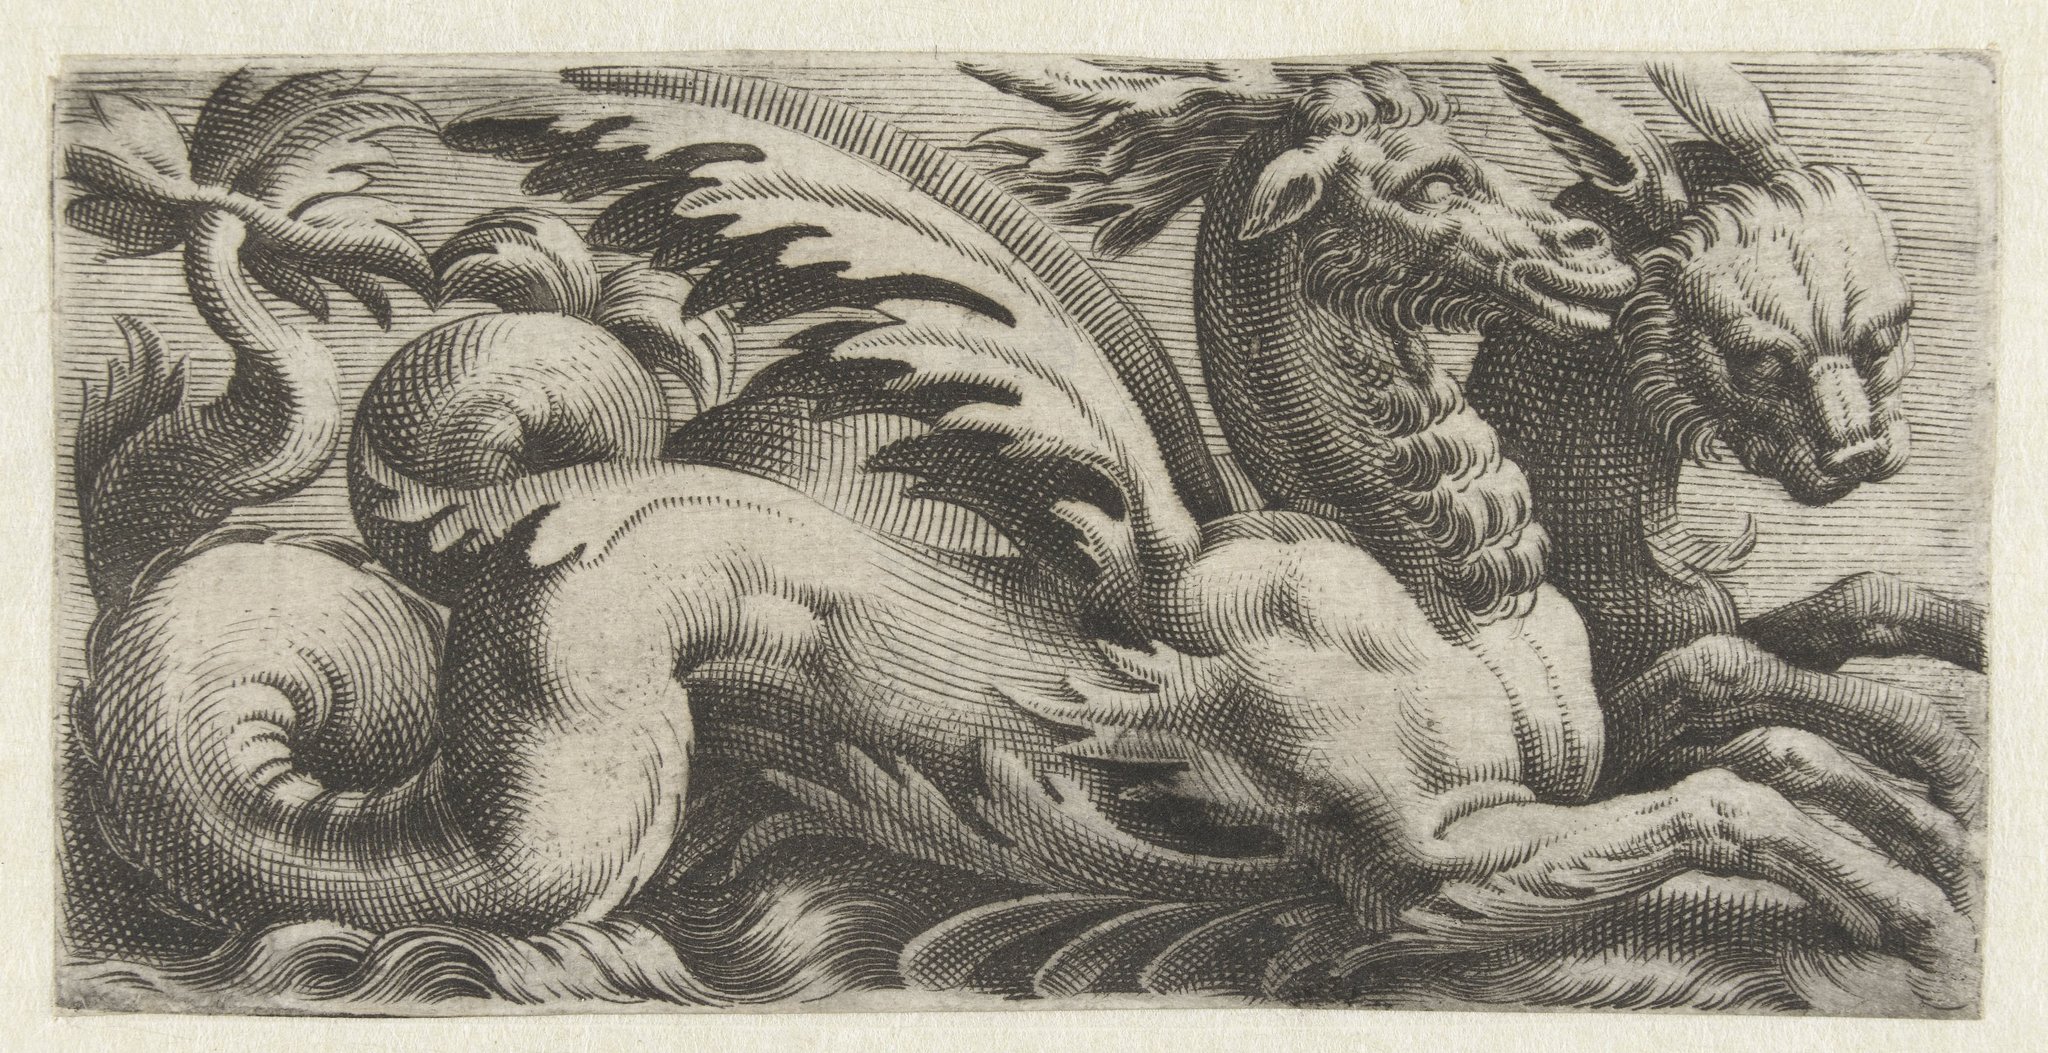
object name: ornament print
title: Twee zeewezens naast elkaar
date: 1580-1610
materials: paper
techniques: engraving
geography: italy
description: Het voorste zeewezen is gevleugeld en heeft een geitenkop. Uit serie van 13 bladen.